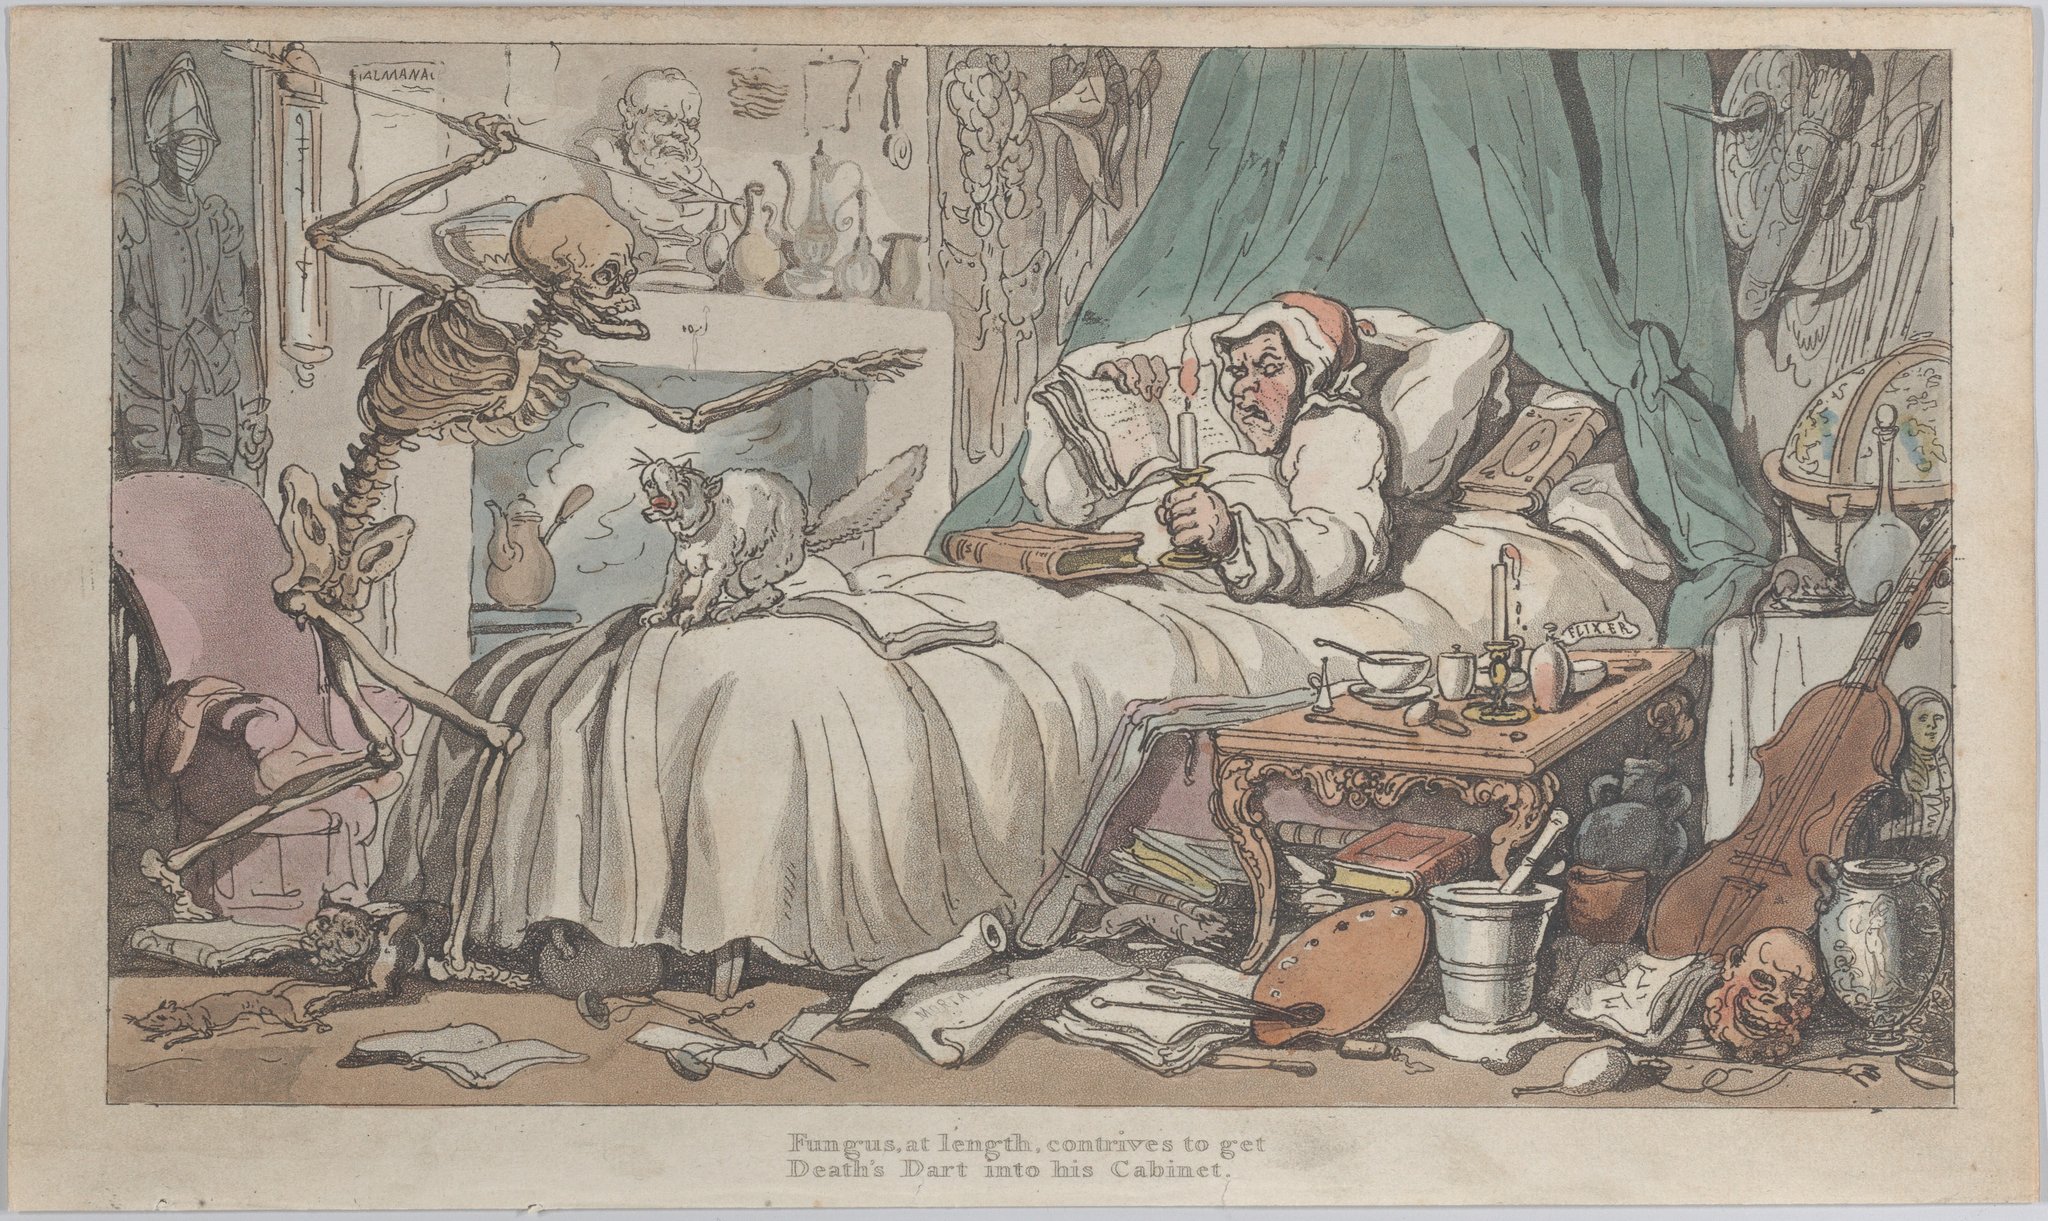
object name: print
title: The Antiquary's Last Will and Testament (from The English Dance of Death, vol. I, plate 2)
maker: thomas rowlandson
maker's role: artist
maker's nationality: british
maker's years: 1757-1827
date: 1816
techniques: etching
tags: satire,bedrooms,skeletons,men,cats,beds